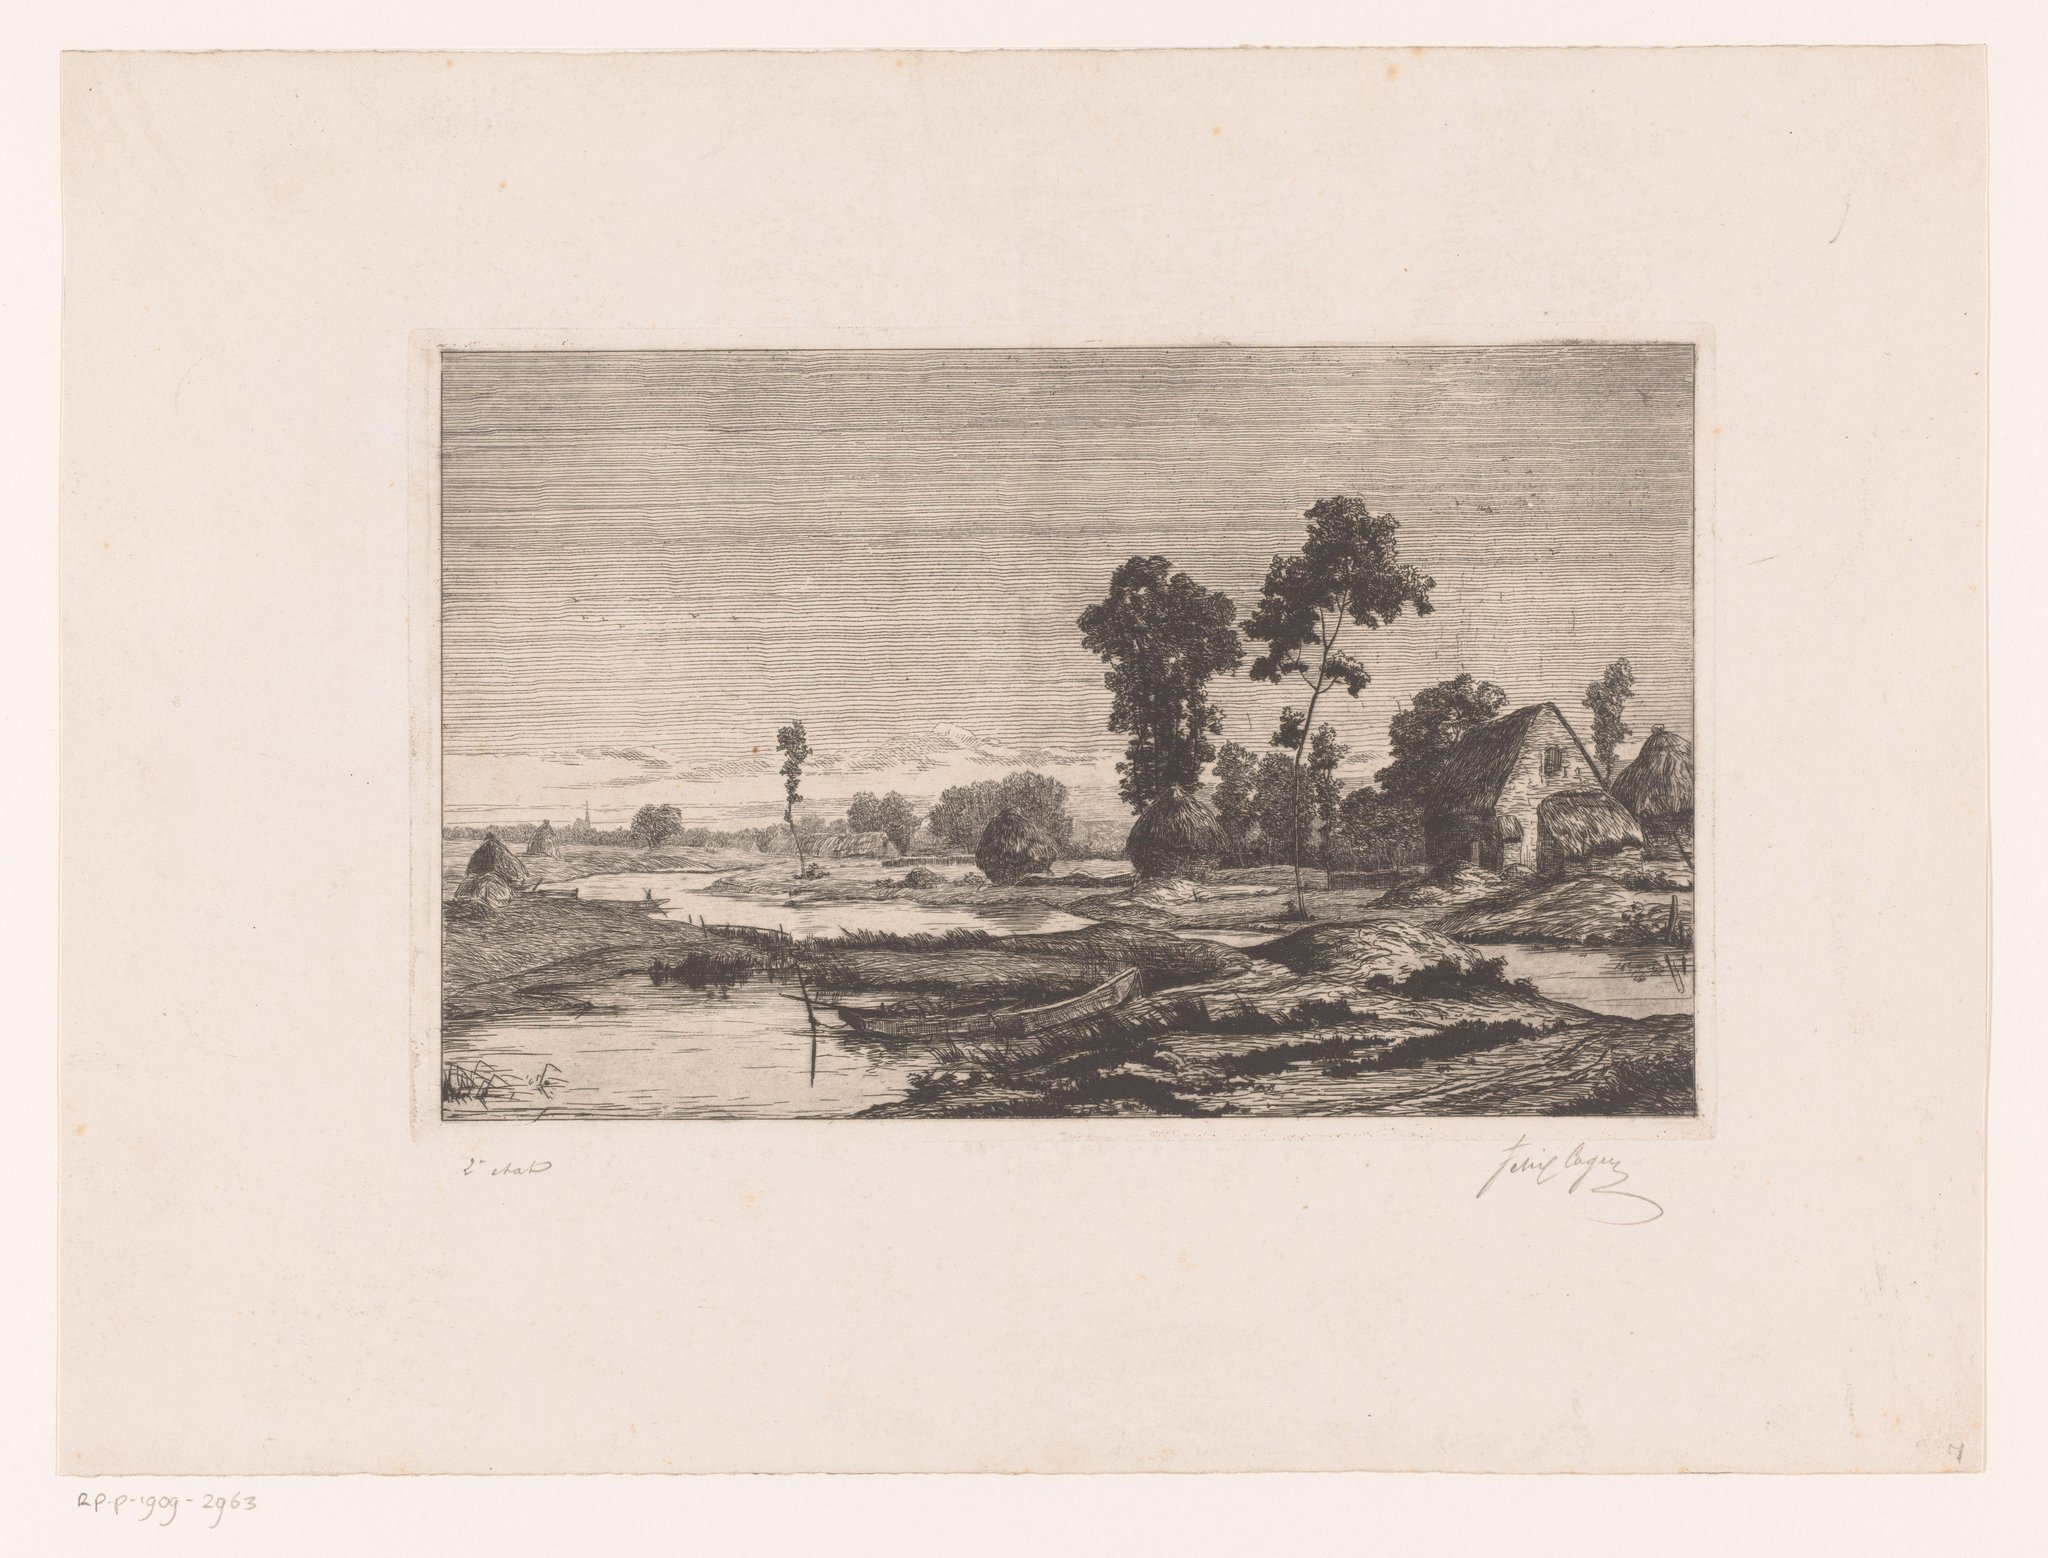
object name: print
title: Waterrijk landschap met boerderij en hooibergen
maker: félix cogen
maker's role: print maker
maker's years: 1838-1907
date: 1848-1907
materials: paper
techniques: drypoint, etching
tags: landscapes, river, hay-stack, farm (building)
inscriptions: collector's mark